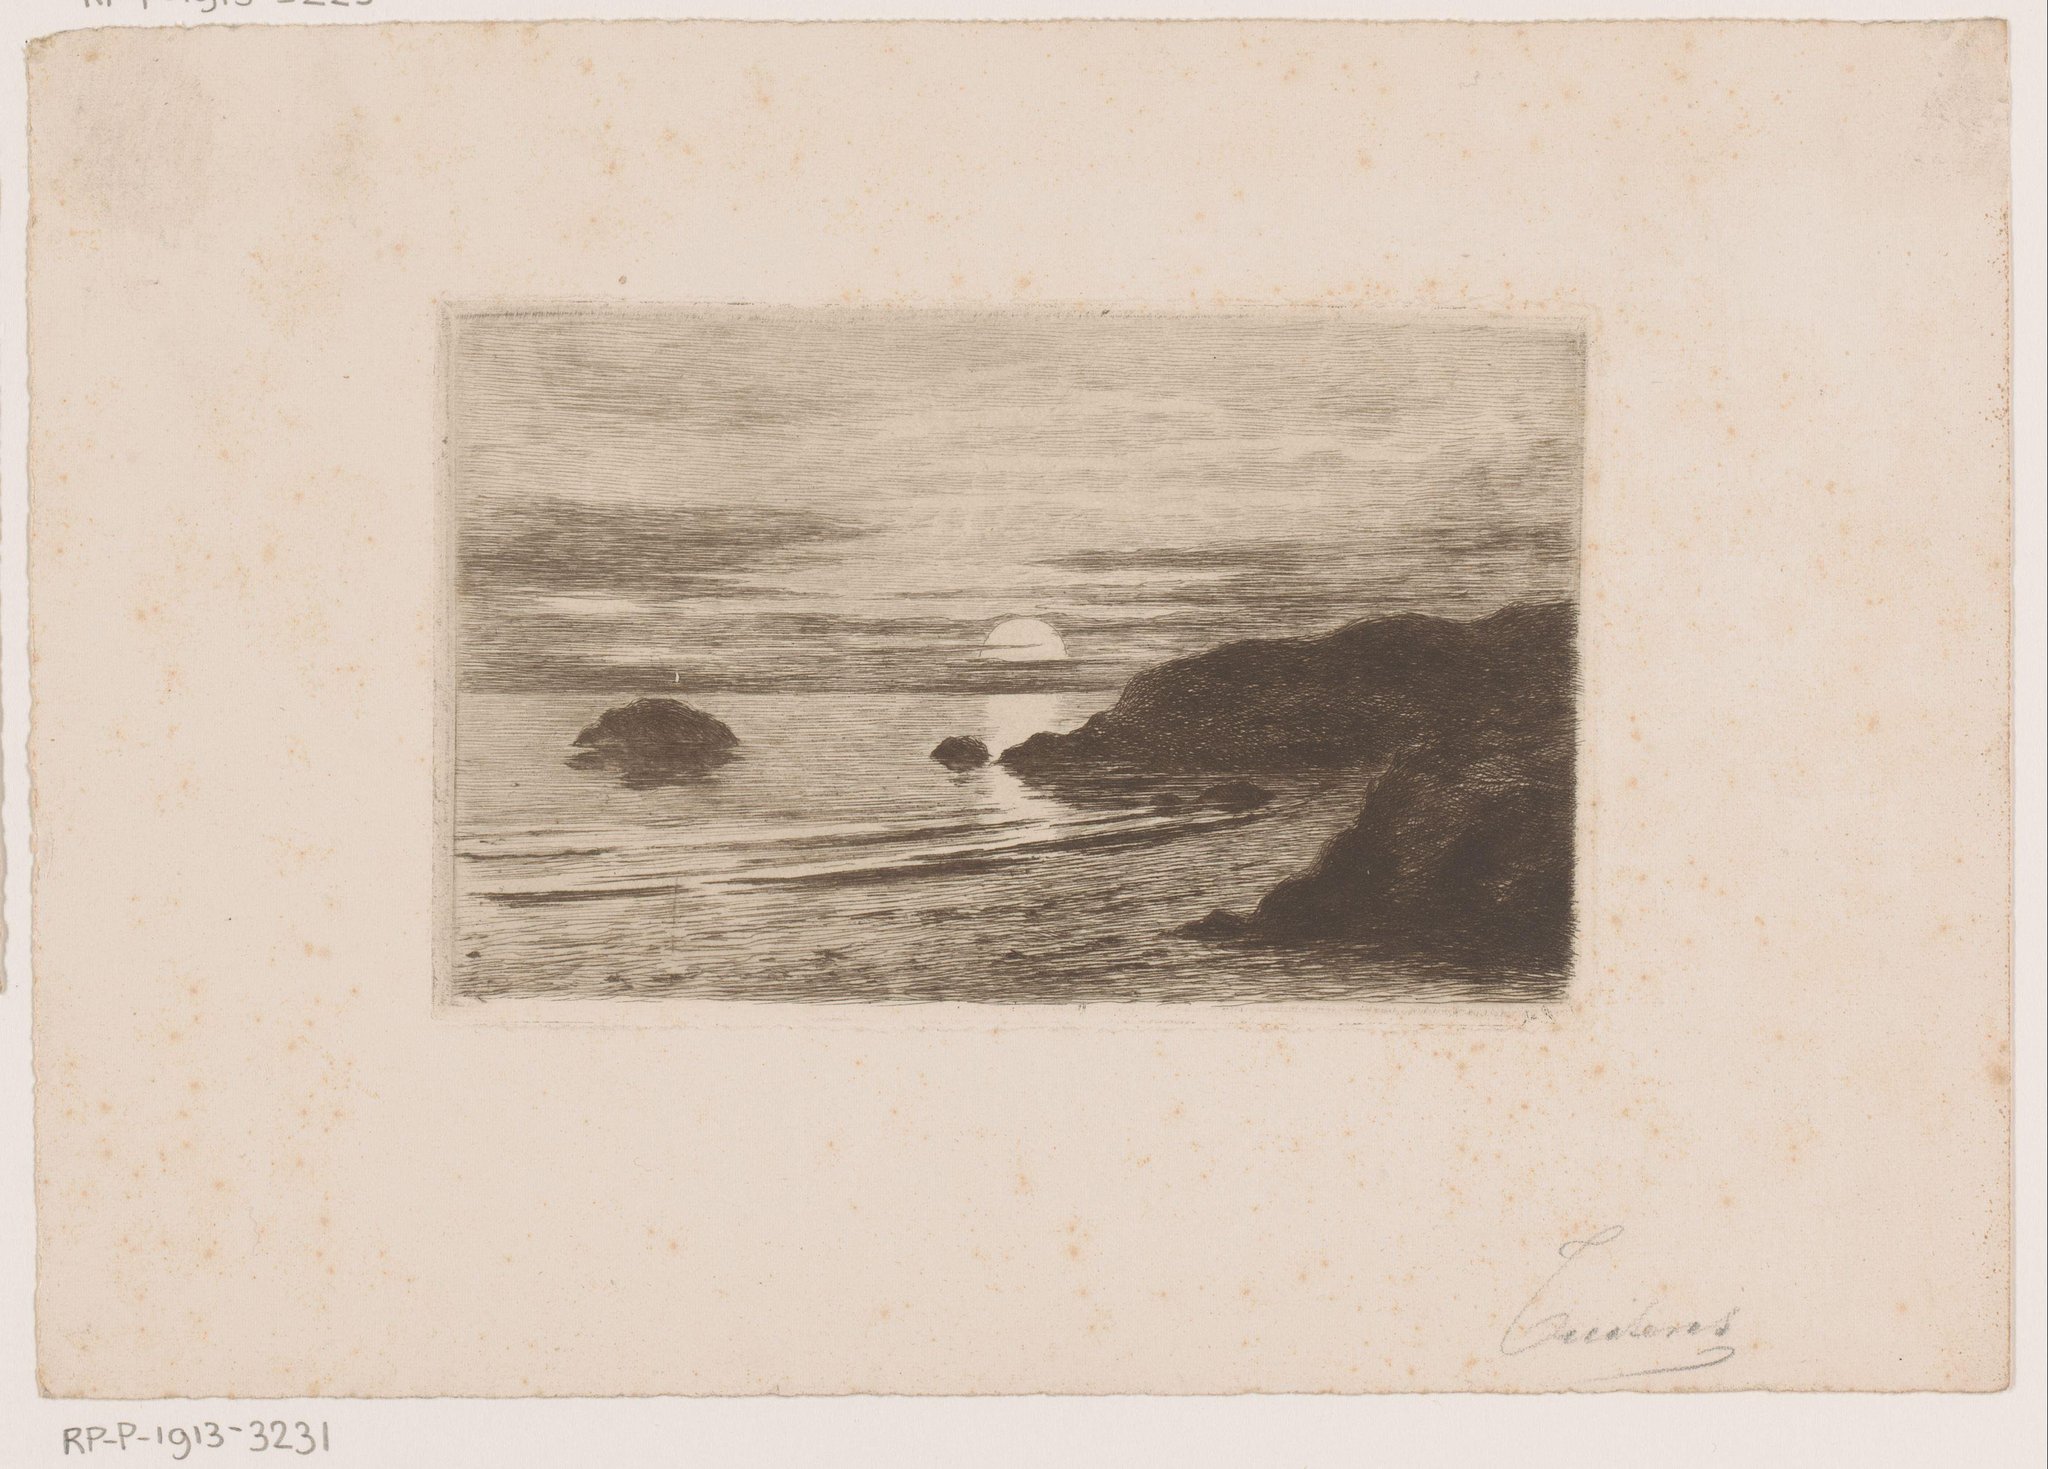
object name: print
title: Zonsondergang aan zee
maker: jerôme tuyttens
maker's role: painter, print maker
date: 1850-1900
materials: paper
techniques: drypoint, etching, intaglio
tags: sea (seascape), sunset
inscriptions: collector's mark: Lugt 2228, annotation: ‘Coucher du sollel en mer/ J. tuytens’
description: Sterfdatum van de prentmaker is onbekend. Daarom is voor de bepaling van de rechten van dit object gebruik gemaakt van de verwervingsdatum Rijksmuseum Amsterdam.